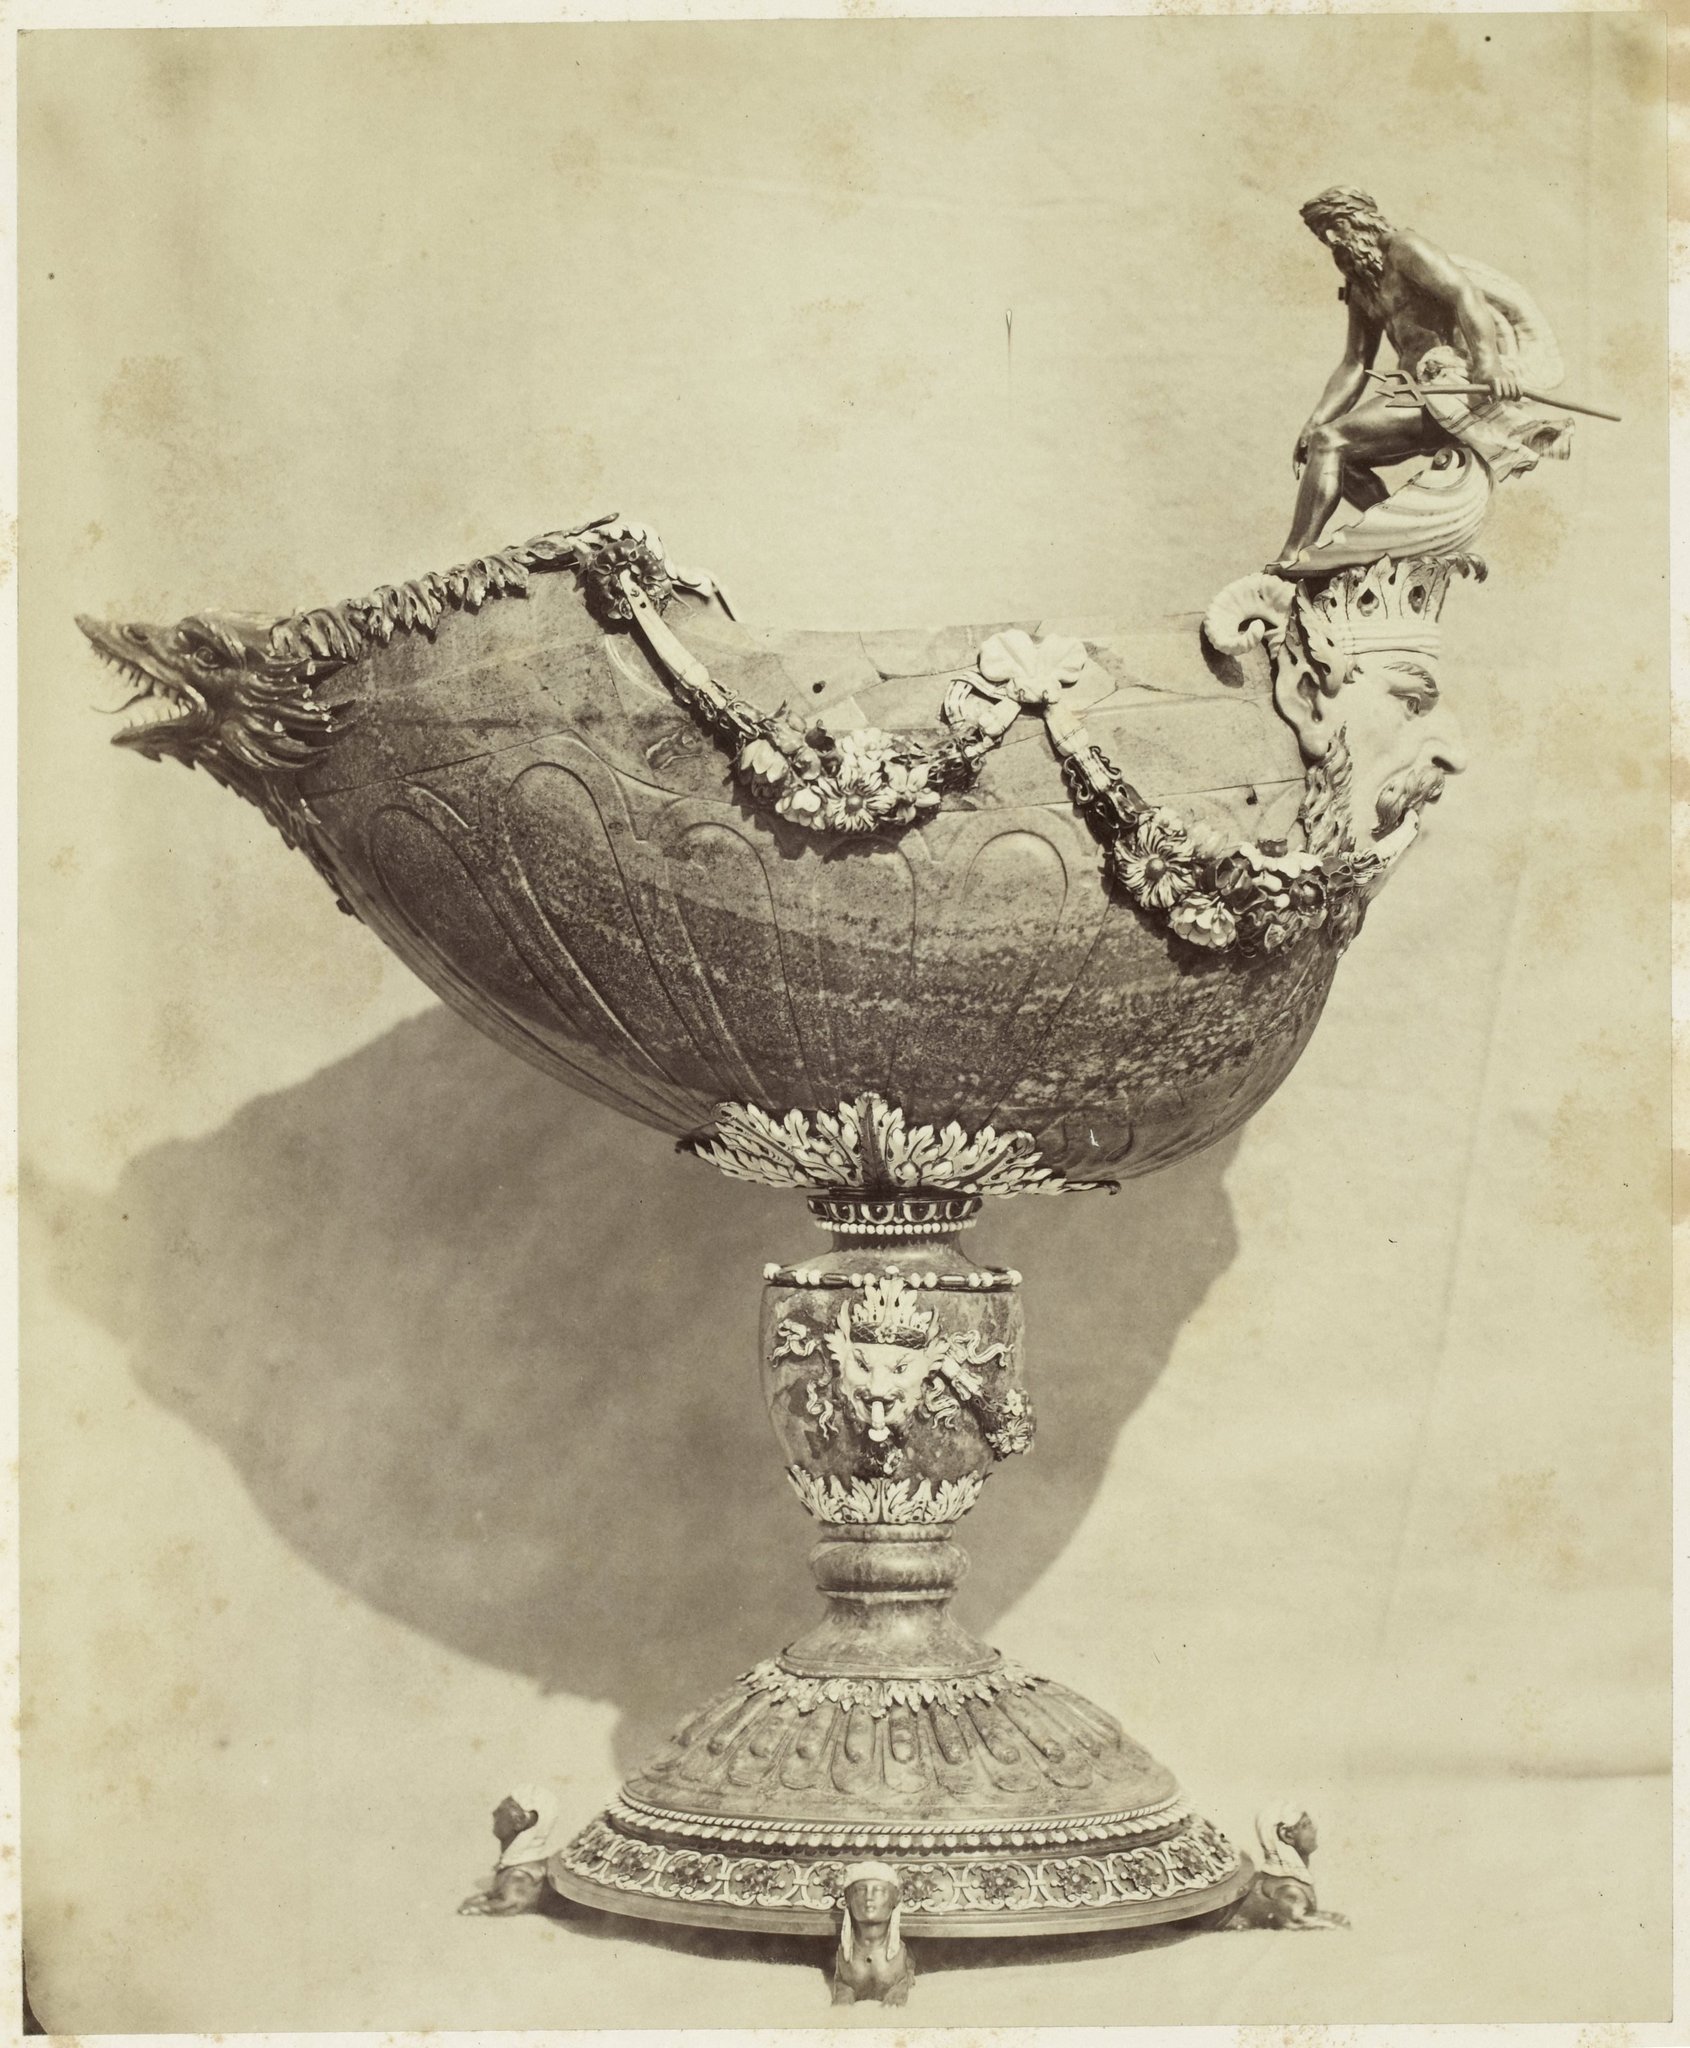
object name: photomechanical print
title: Schelpvormige schaal met Neptunusfiguur, uit het Louvre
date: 1866-1890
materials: paper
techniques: woodburytype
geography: louvre museum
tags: scallop, shell ~ ornament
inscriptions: inscription: ‘Photographed by C. Thurston Thompson.’